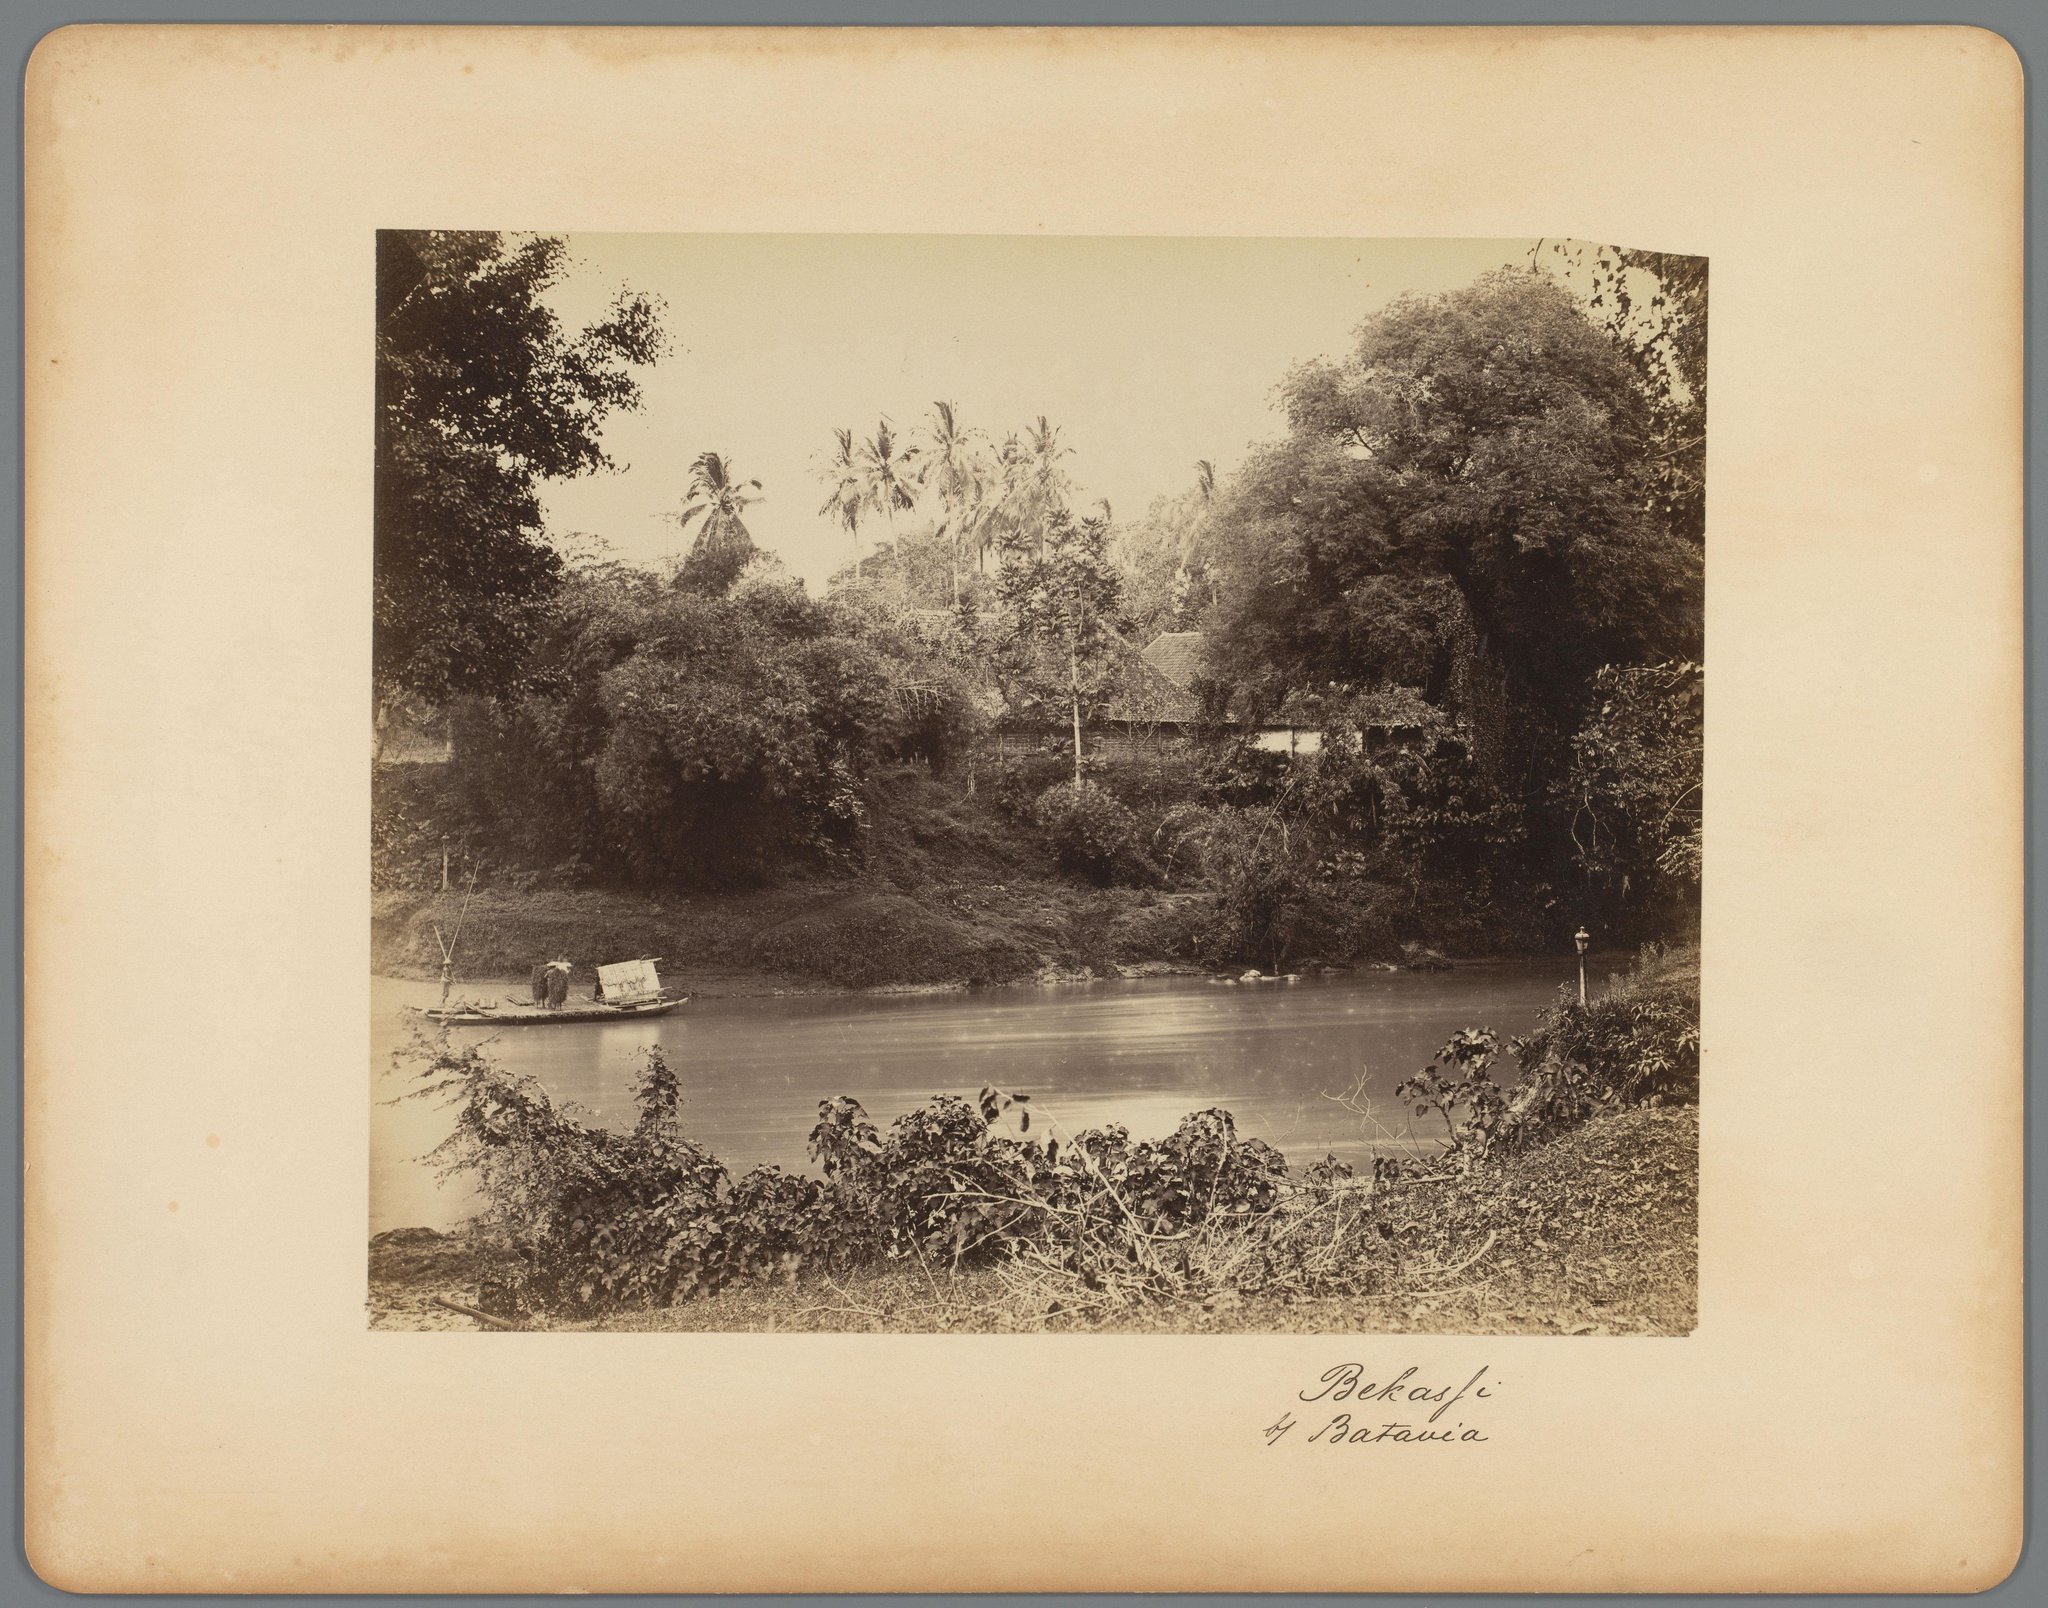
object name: photograph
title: Bekassi. Batavia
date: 1857-1908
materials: cardboard, paper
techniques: albumen print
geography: bekasi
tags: river, village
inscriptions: inscription: ‘PHOTOGRAFIEEN VAN NED: INDIE BATAVIA’, inscription: ‘FOTO’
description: Deze foto zat oorspronkelijk in prentenkabinet RP-F-AA3192.